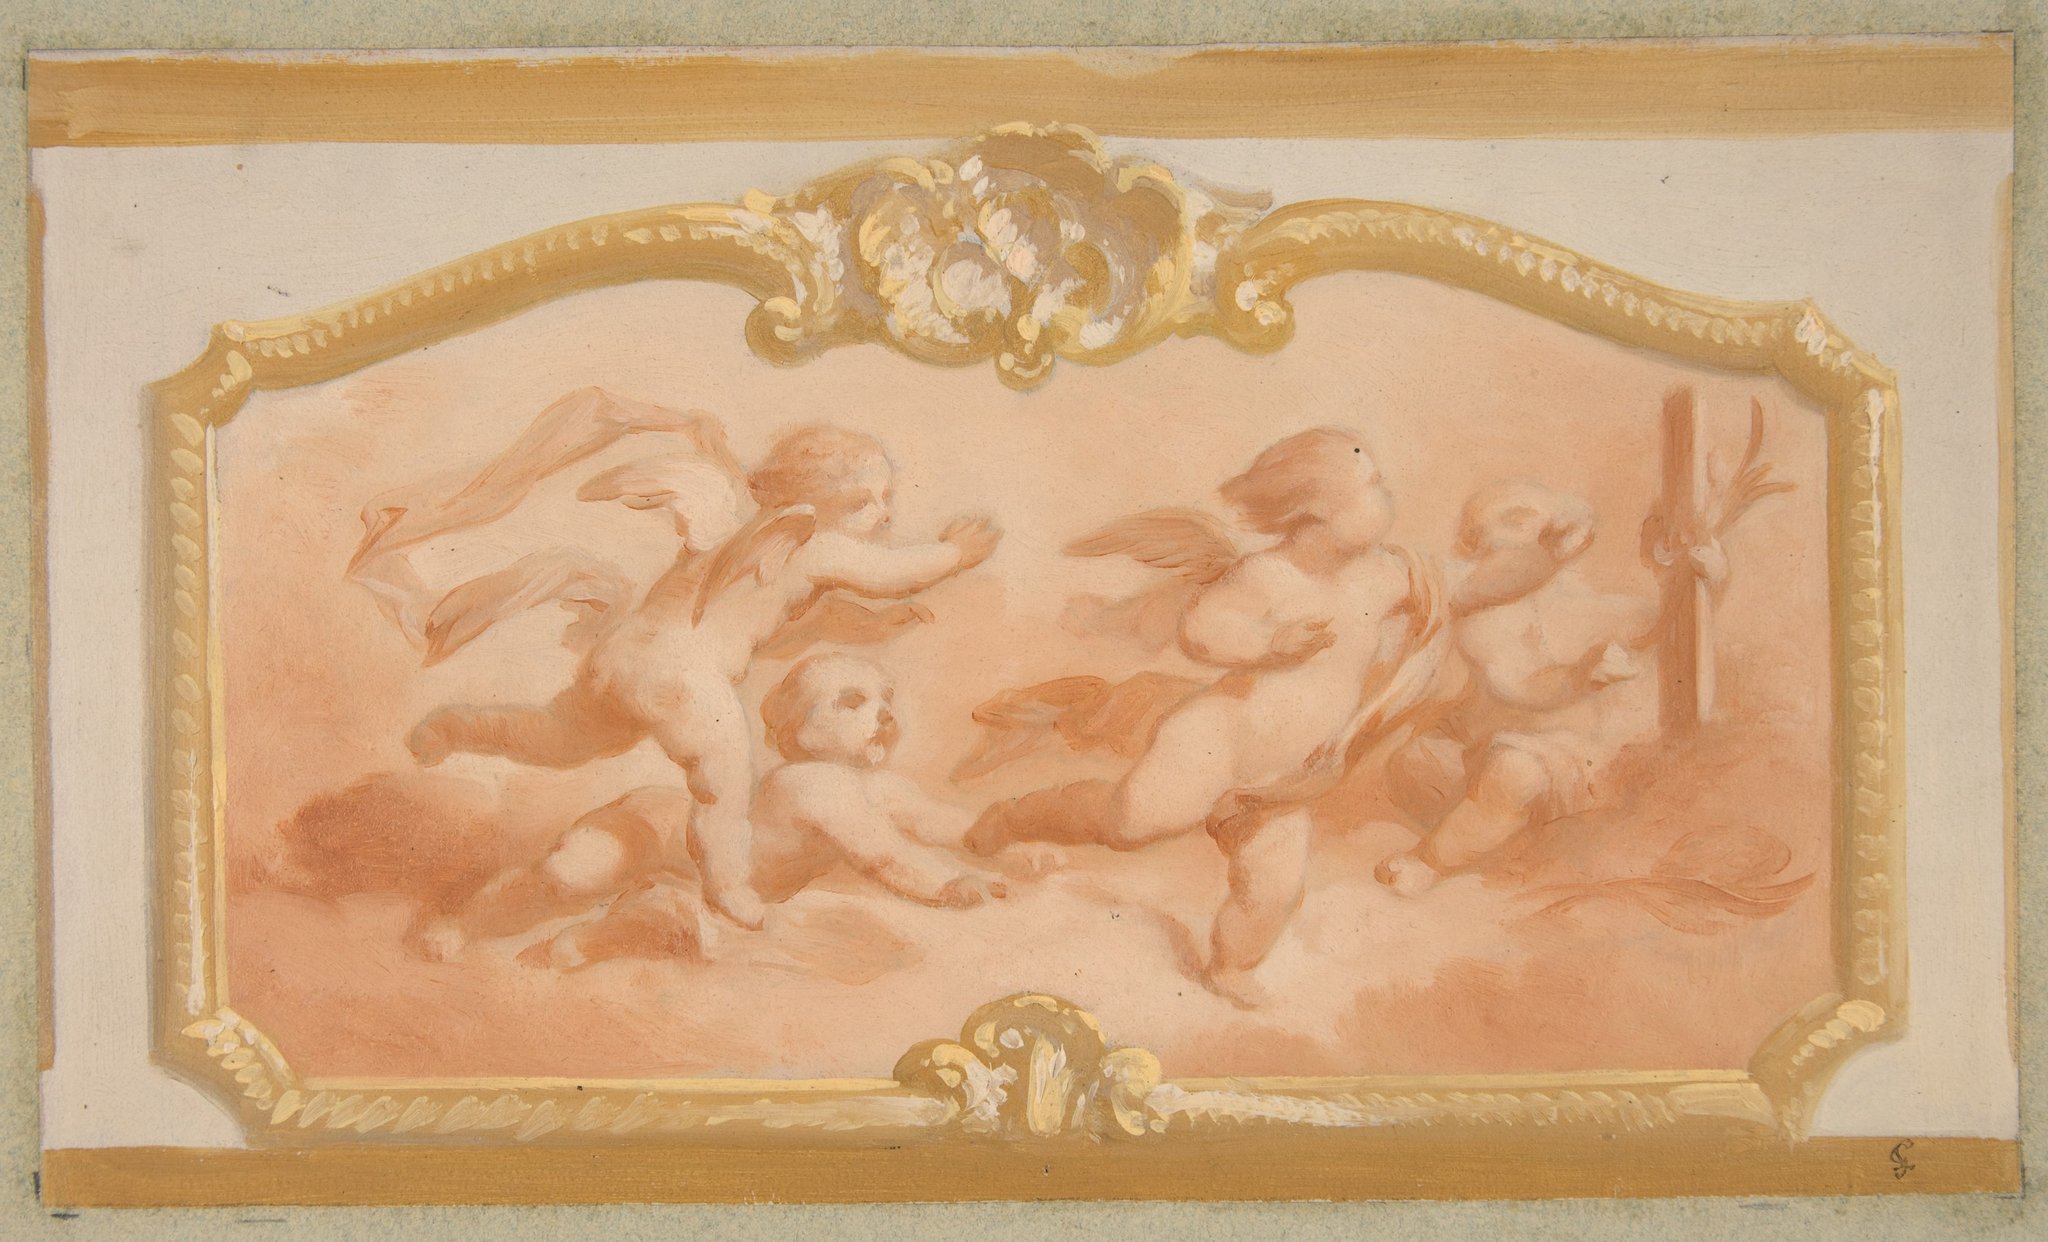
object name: drawing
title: Design with putti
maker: jules-edmond-charles lachaise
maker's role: artist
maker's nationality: french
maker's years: 1897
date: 1851-1900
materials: oil